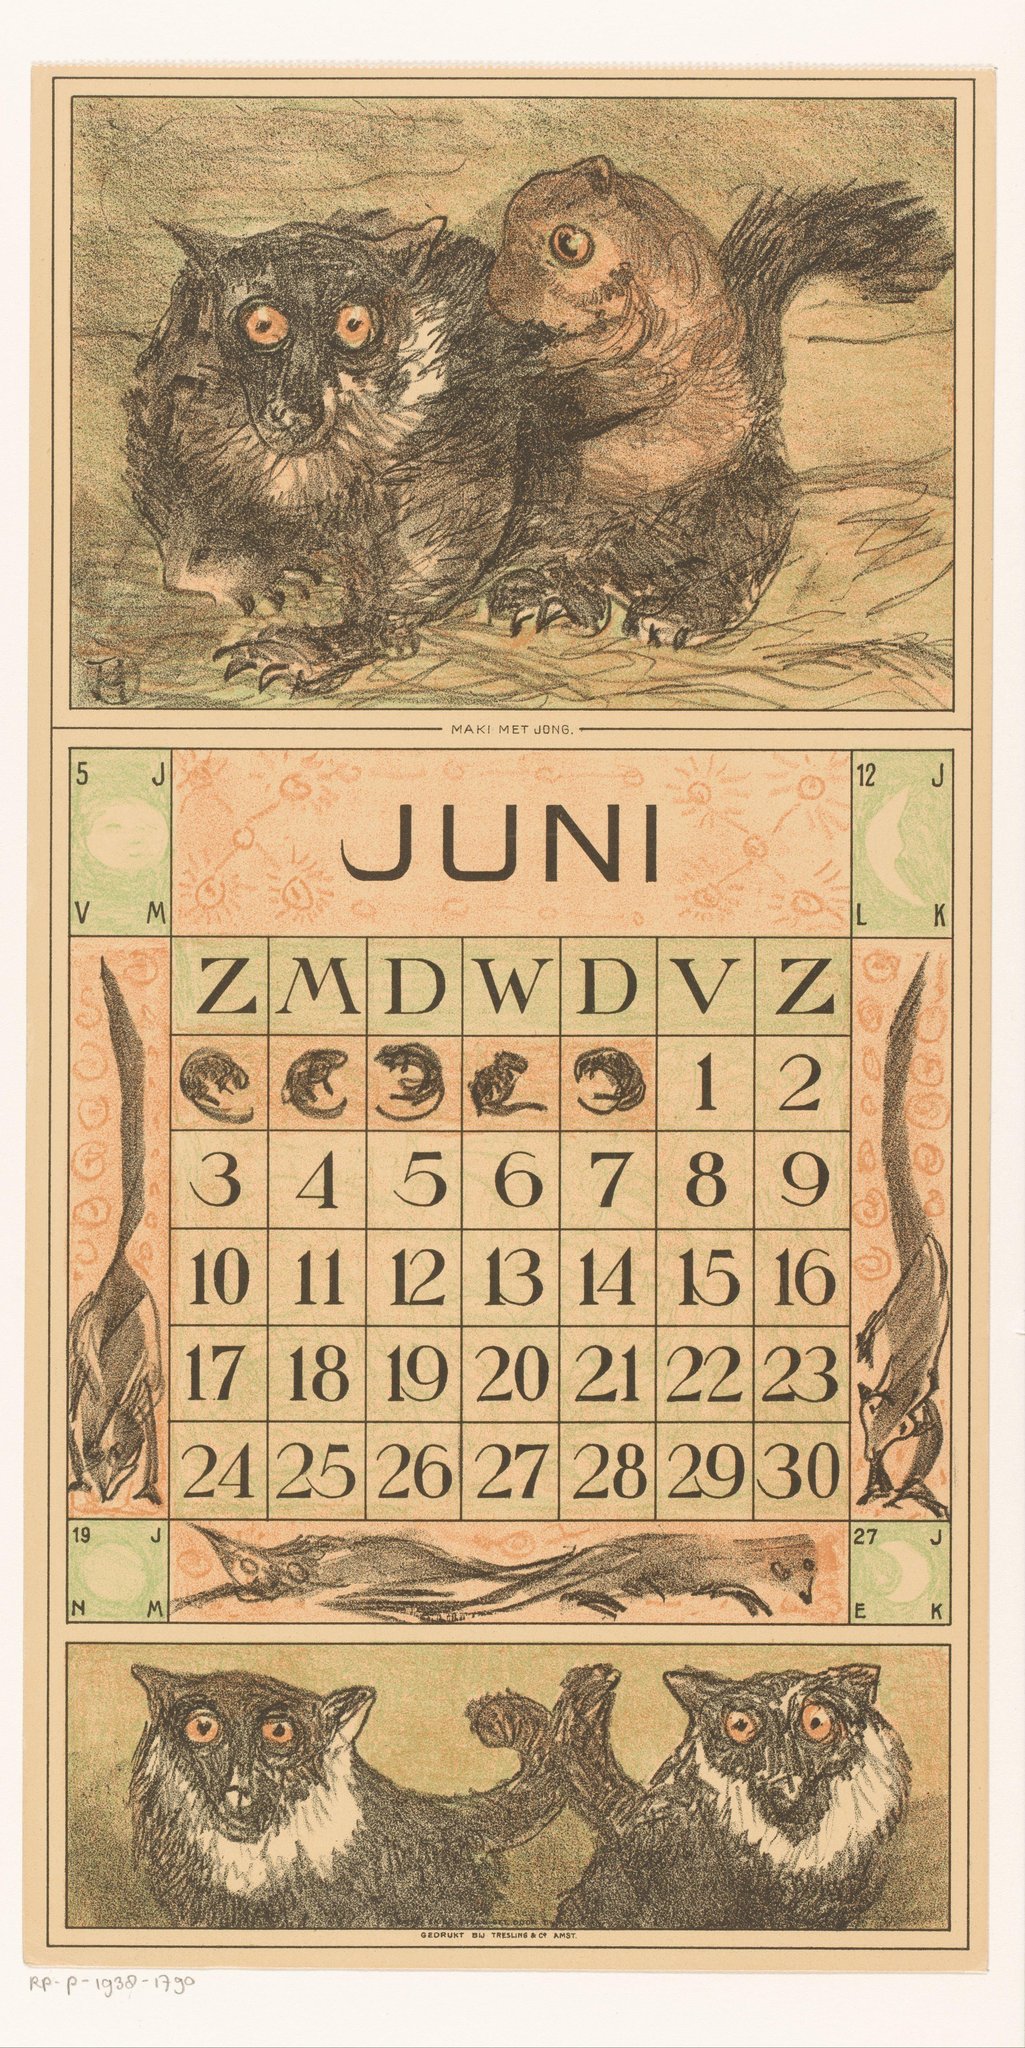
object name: print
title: Kalender 1917 12 lithografien door Th. v. Hoytema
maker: theo van hoytema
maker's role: draughtsman, painter, print maker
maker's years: 1863-1917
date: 1916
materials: paper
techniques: lithograph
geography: amsterdam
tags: monkeys, apes, lunar year, june ~ other concepts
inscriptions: collector's mark: Lugt 2228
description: Onderin twee volwassen maki's. In de hoeken de standen van de maan op vier dagen. Bovenaan het blad een scheurlijn.